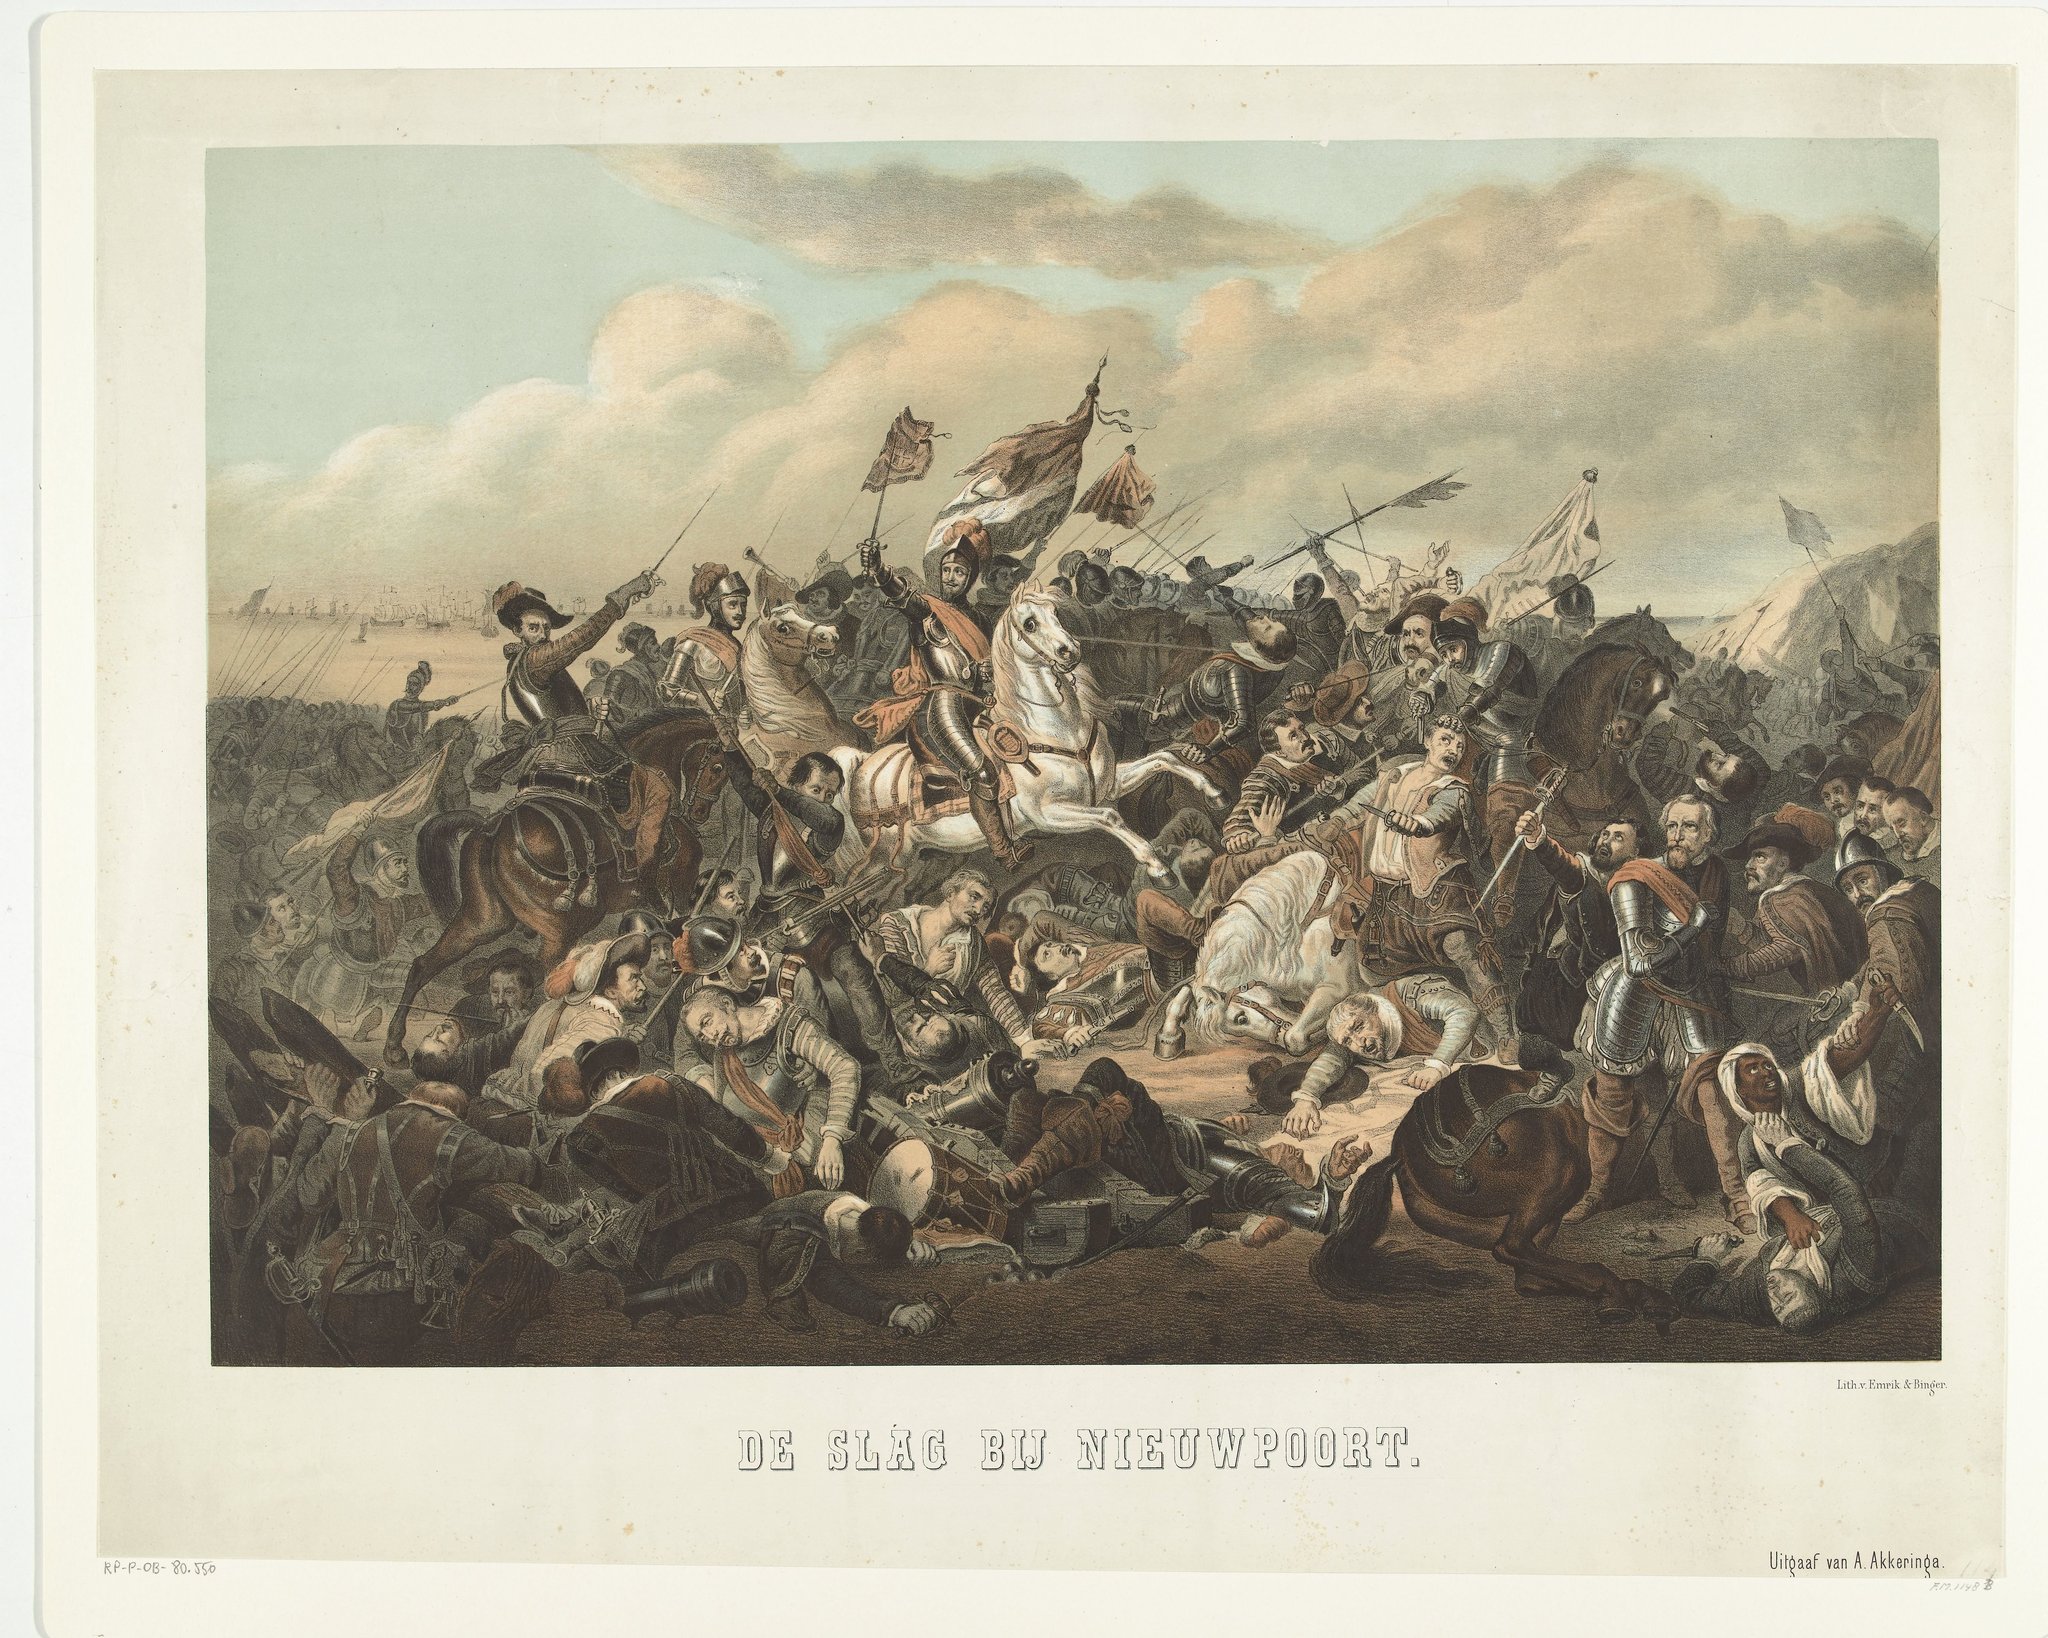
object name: print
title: Slag bij Nieuwpoort, 1600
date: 1825-1899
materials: paper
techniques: lithograph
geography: netherlands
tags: the hague, maurice (prince of orange), battle (+ land forces), battle of nieuwpoort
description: Strijdtafereel tijdens de slag bij Nieuwpoort, 2 juli 1600. In het midden prins Maurits te paard. Rechtsvoor wordt Francisco de Mendoza gevangengenomen.